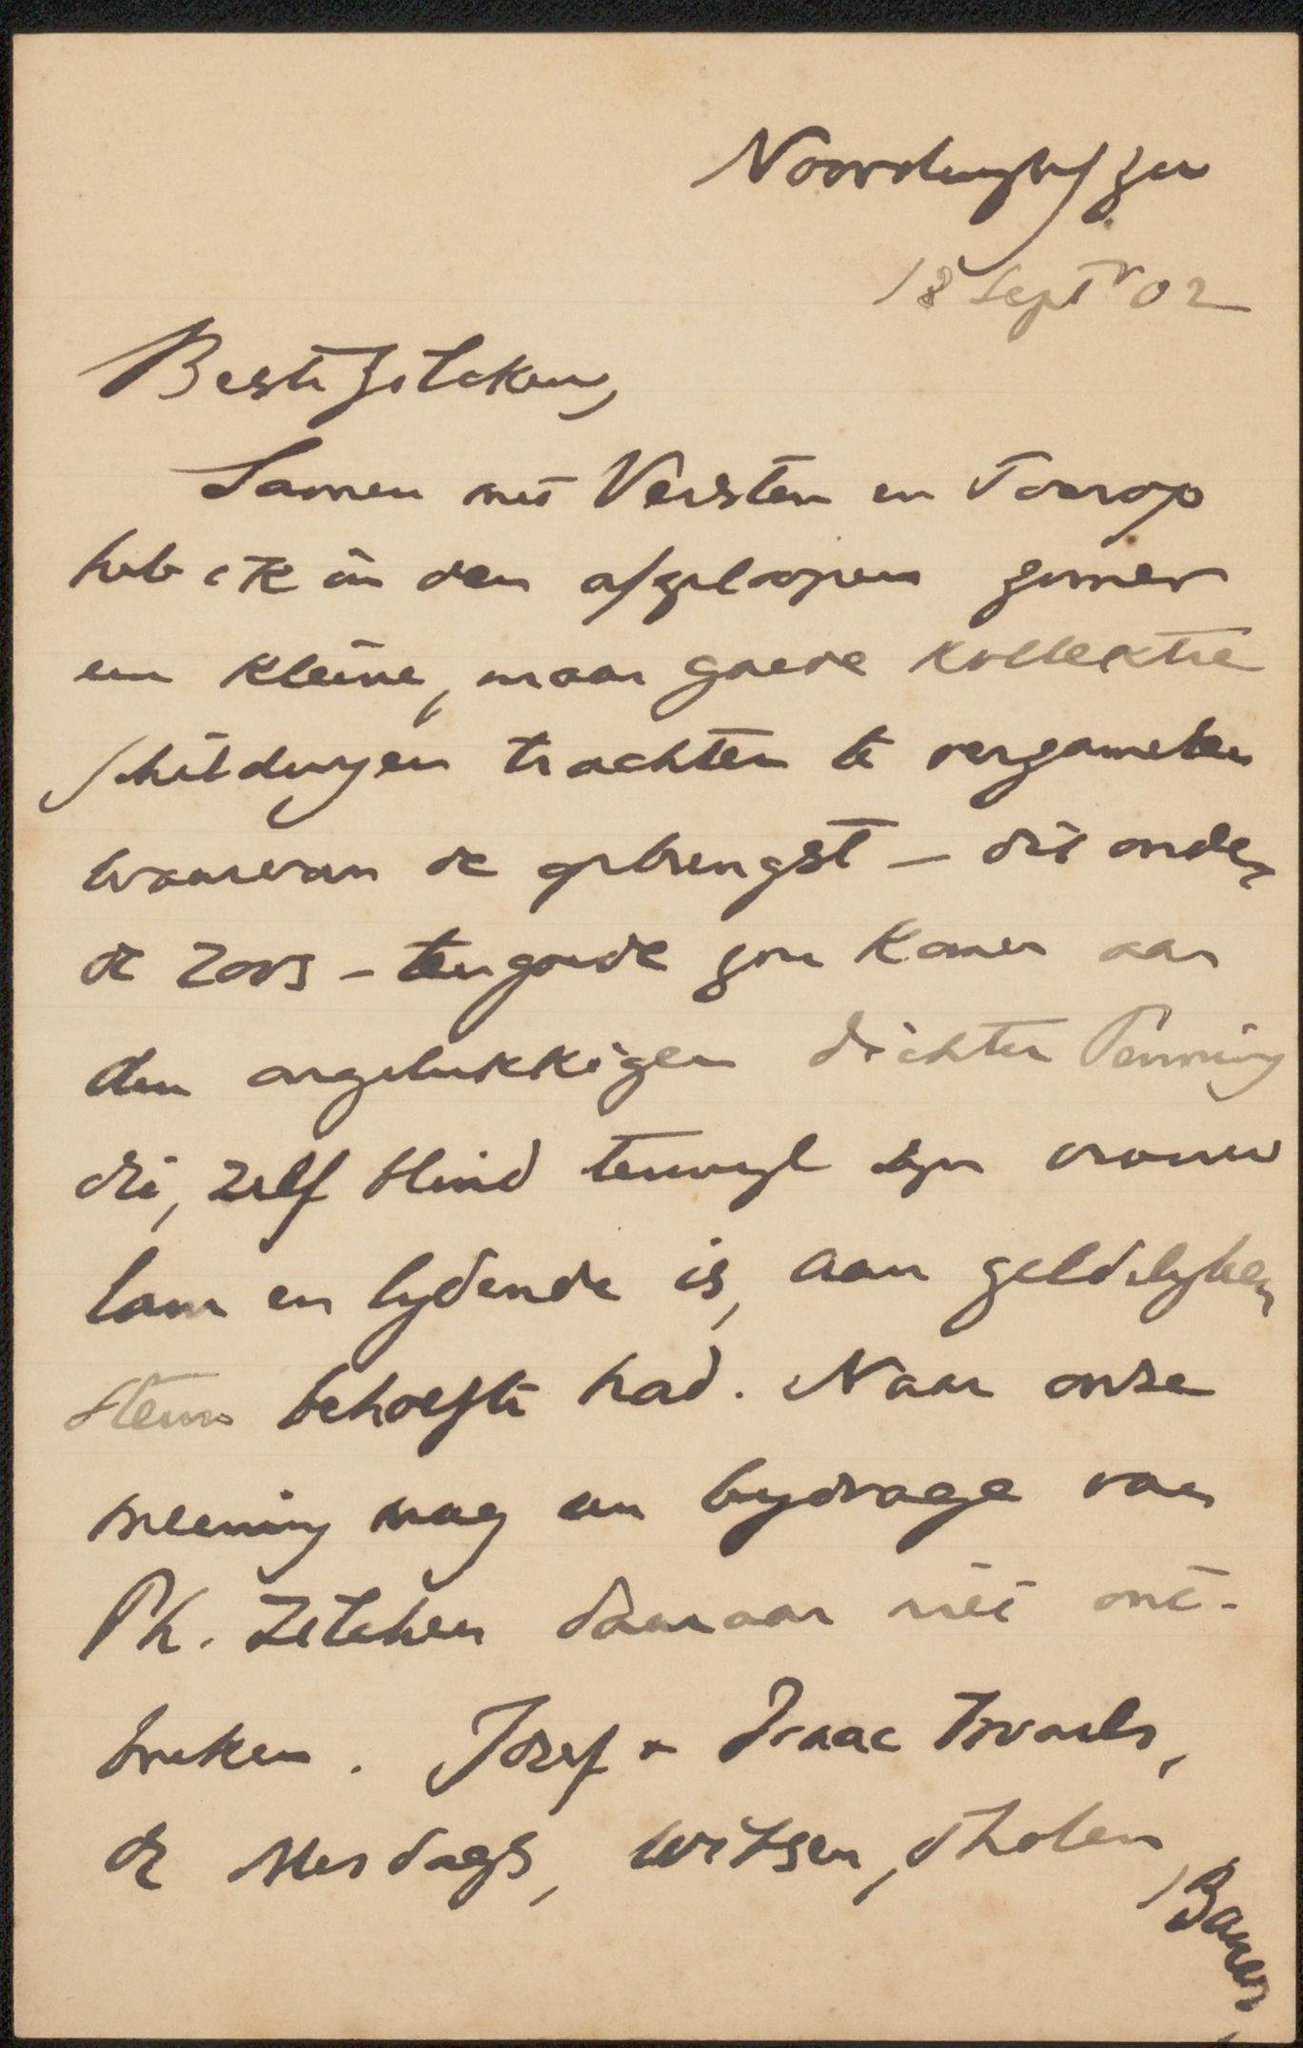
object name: letter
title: Brief aan Philip Zilcken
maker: albert verwey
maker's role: criticus, dichter, essayist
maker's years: 1865-1937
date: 1902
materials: ink, paper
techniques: pen, writing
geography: noordwijk aan zee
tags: jozef israëls, haarlem, théophile de bock, hendrik willem mesdag, the hague, painter, print maker, draughtsman, johan hendrik weissenbruch, carel nicolaas storm van 's-gravesande, isaac israels, jan voerman (1857-1941), willem witsen, willem bastiaan tholen, marius bauer, jan toorop, leiden, floris verster, berend wolter weyers, richard bisschop, hermanus gijsbertus tersteeg, philip zilcken, painting (including book-illumination, miniature-painting), charitable works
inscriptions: watermark, collector's mark: ‘RPK’